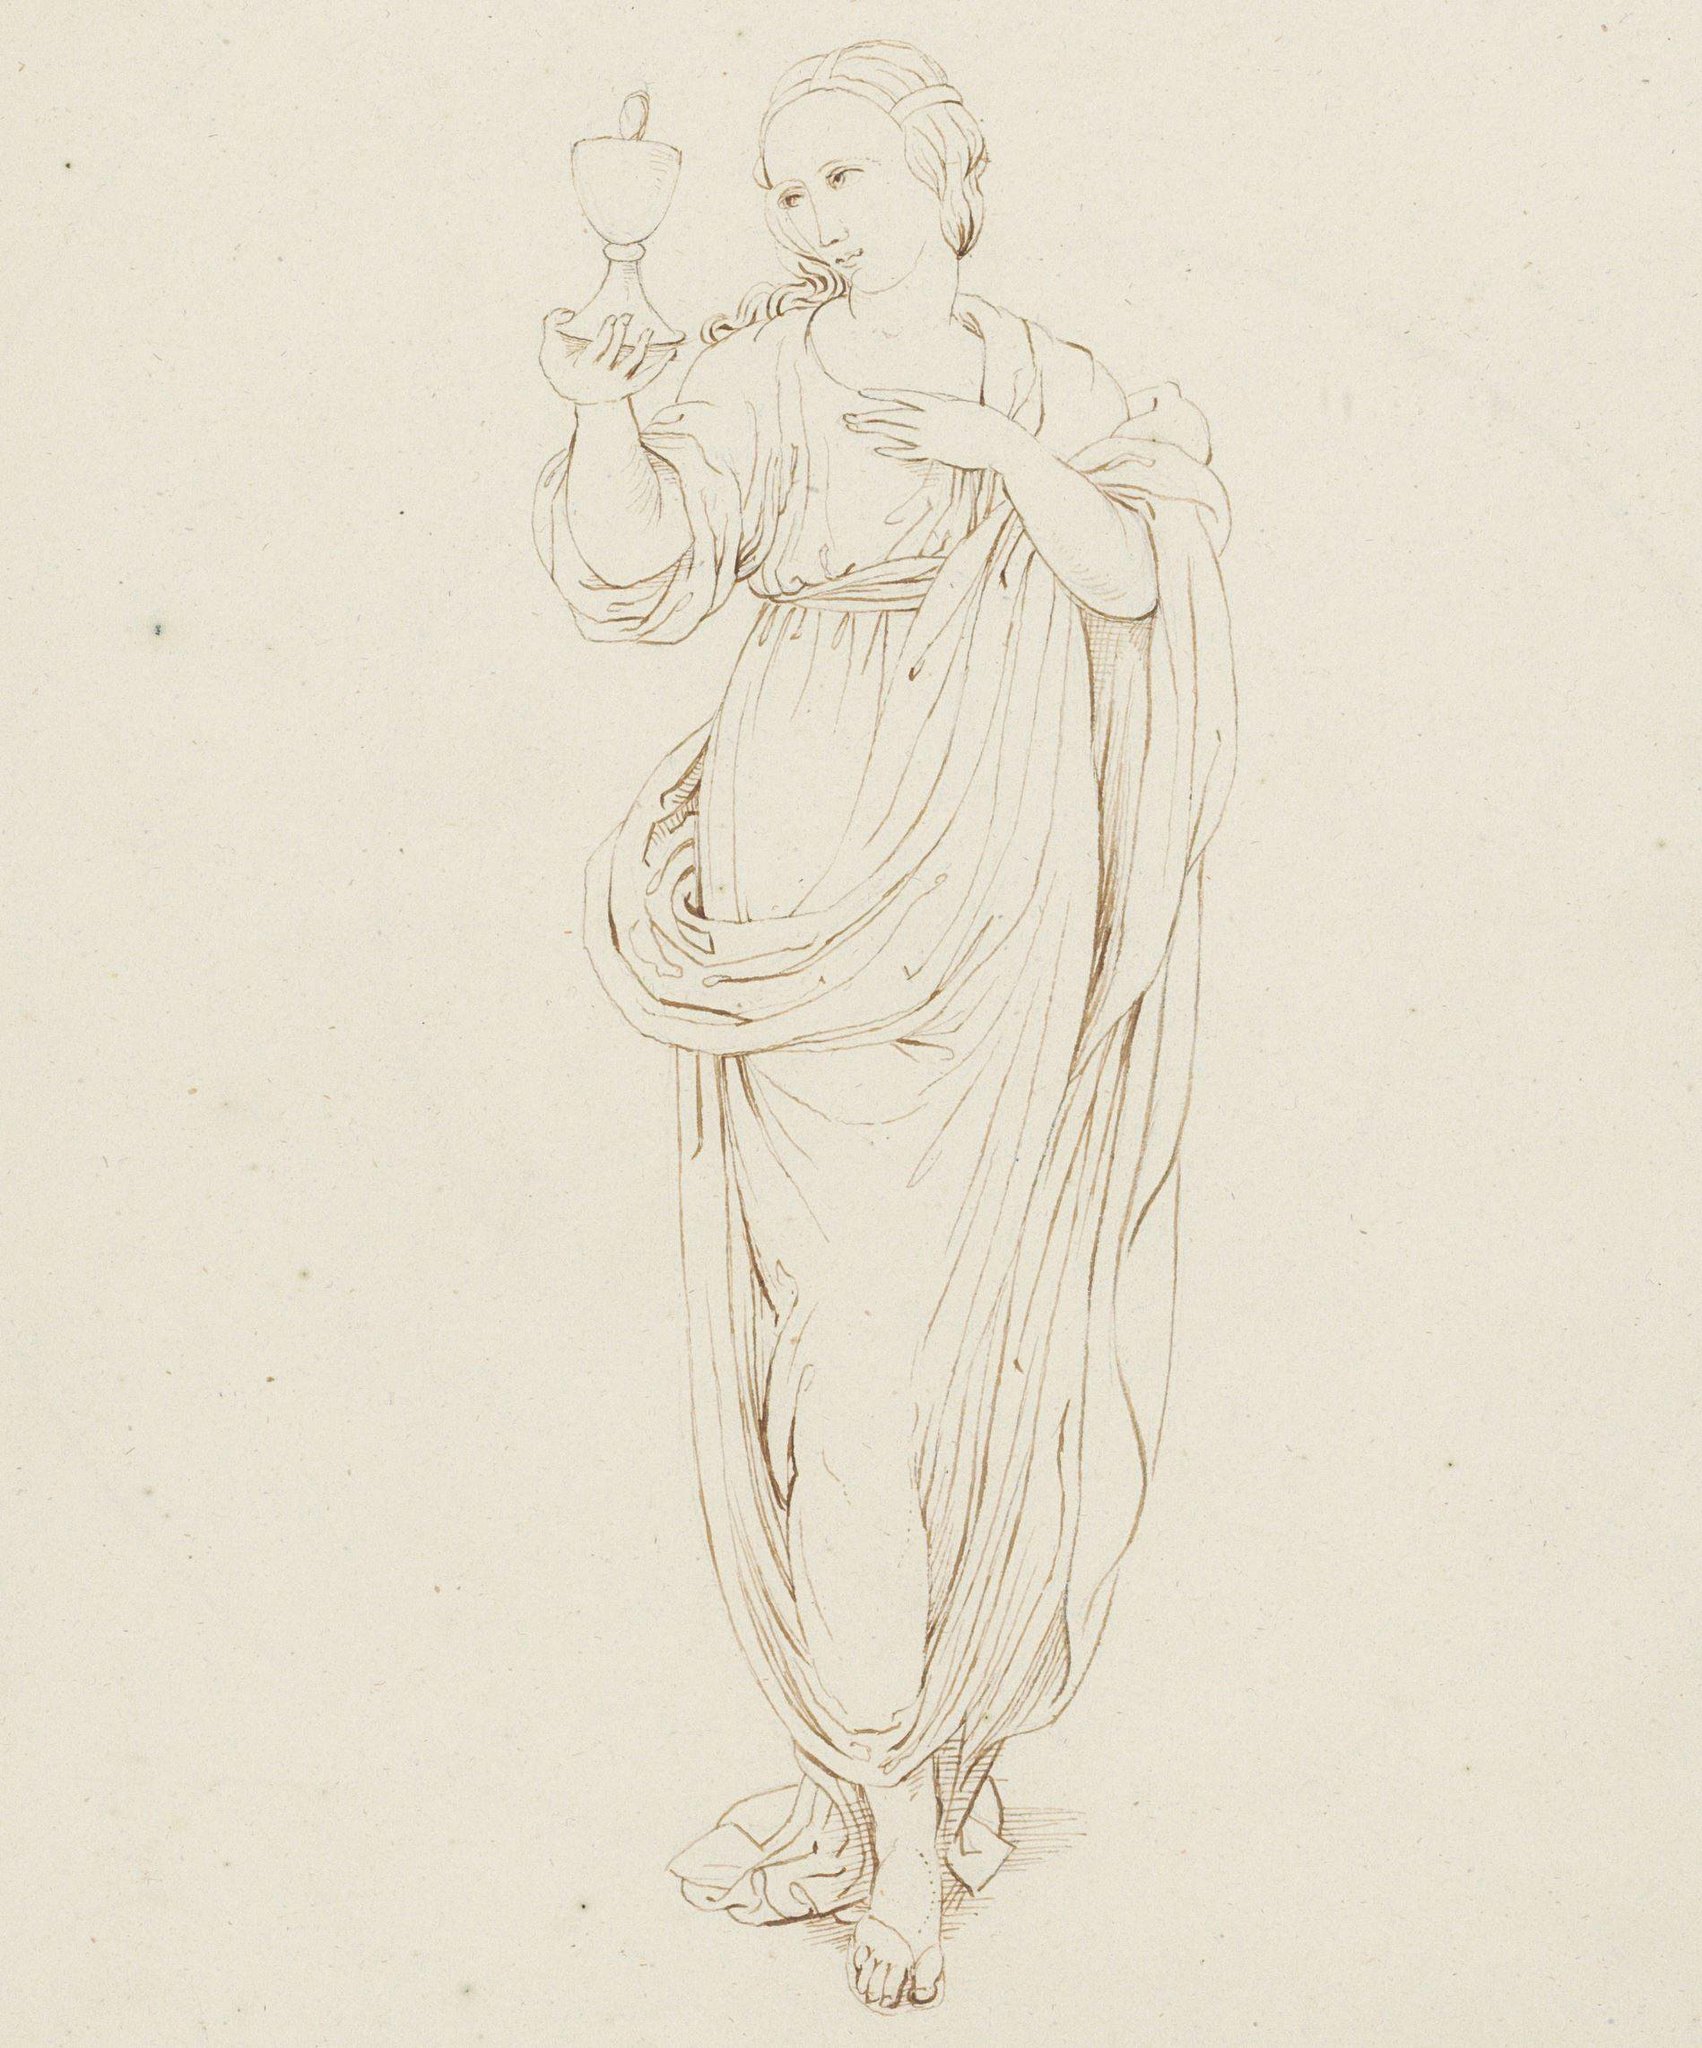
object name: sketchbook leaf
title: Maria Magdalena met zalfpot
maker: jonkvrouw elisabeth kemper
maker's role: draughtsman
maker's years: 1799-1871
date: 1822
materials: ink, paper, pencil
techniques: pen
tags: the penitent harlot mary magdalene; possible attributes: book (or scroll), crown, crown of thorns, crucifix, jar of ointment, mirror, musical instrument, palm-branch, rosary, scourge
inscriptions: date: ‘1822’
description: Blad 44 recto uit een schetsboek met 94 bladen.